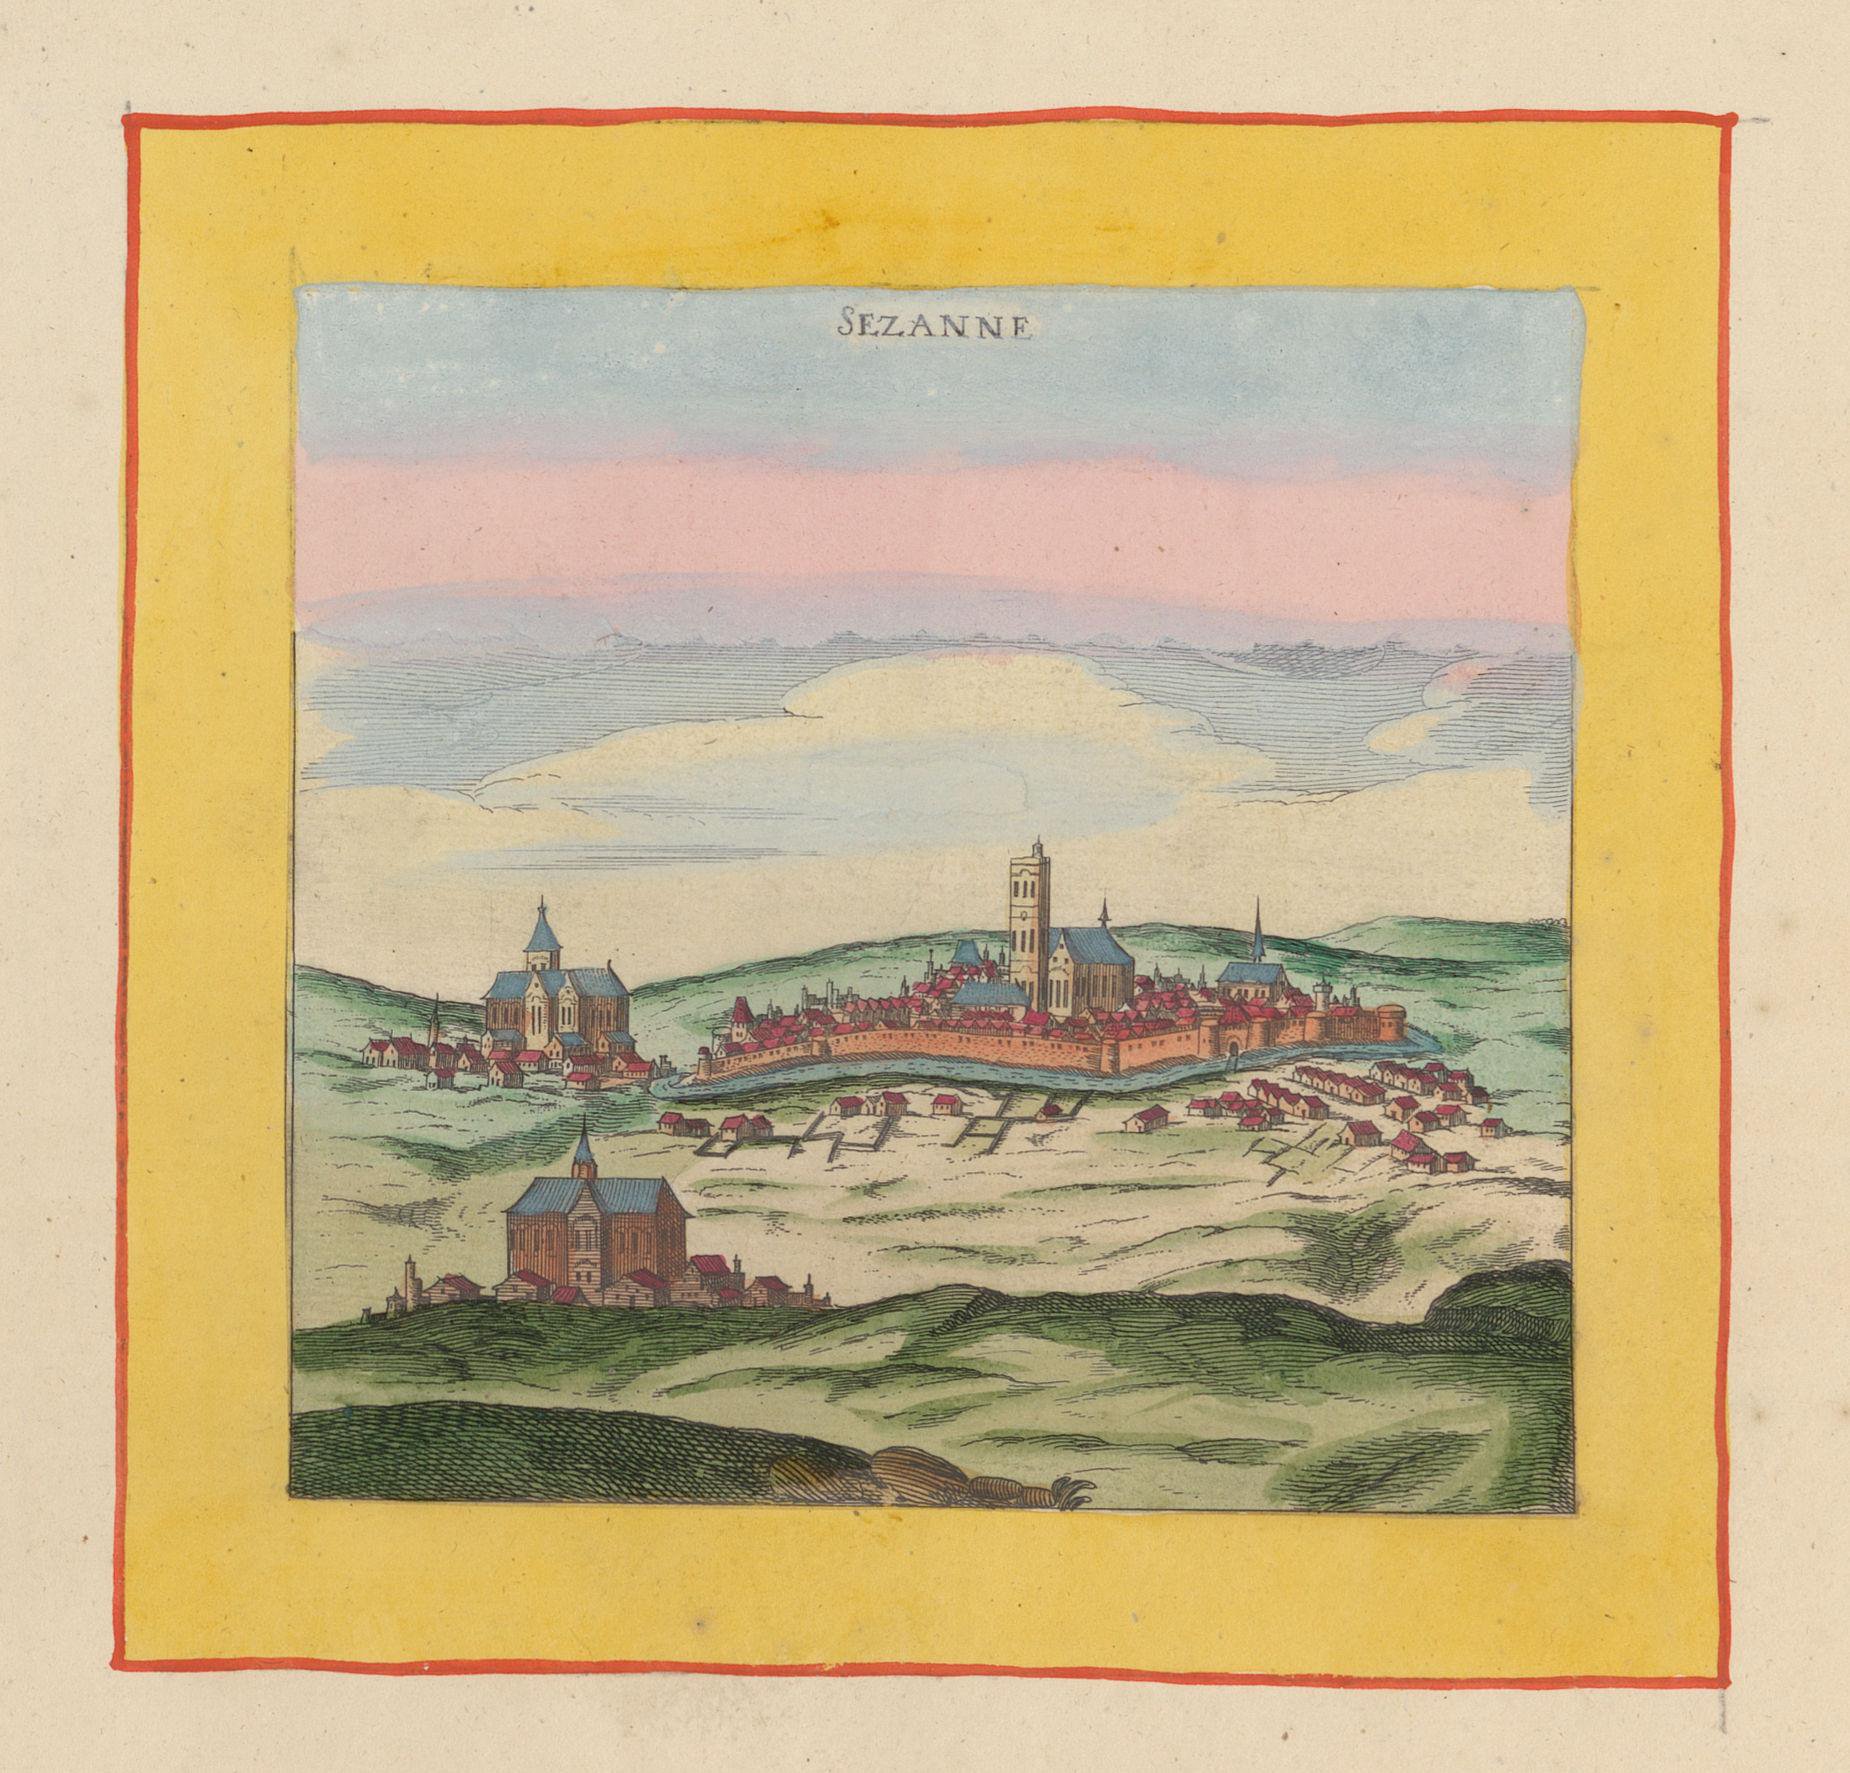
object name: print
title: Sezanne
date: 1638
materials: paper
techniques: engraving, hand coloring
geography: paris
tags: city-view in general; 'veduta'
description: Prent uit: Tassin, Christophe. Les plans et profils de toutes les principales villes et lieux considérables de France (...). Parijs: Michel van Lochom, 1638, prent 10 uit het deel 'Brie'.